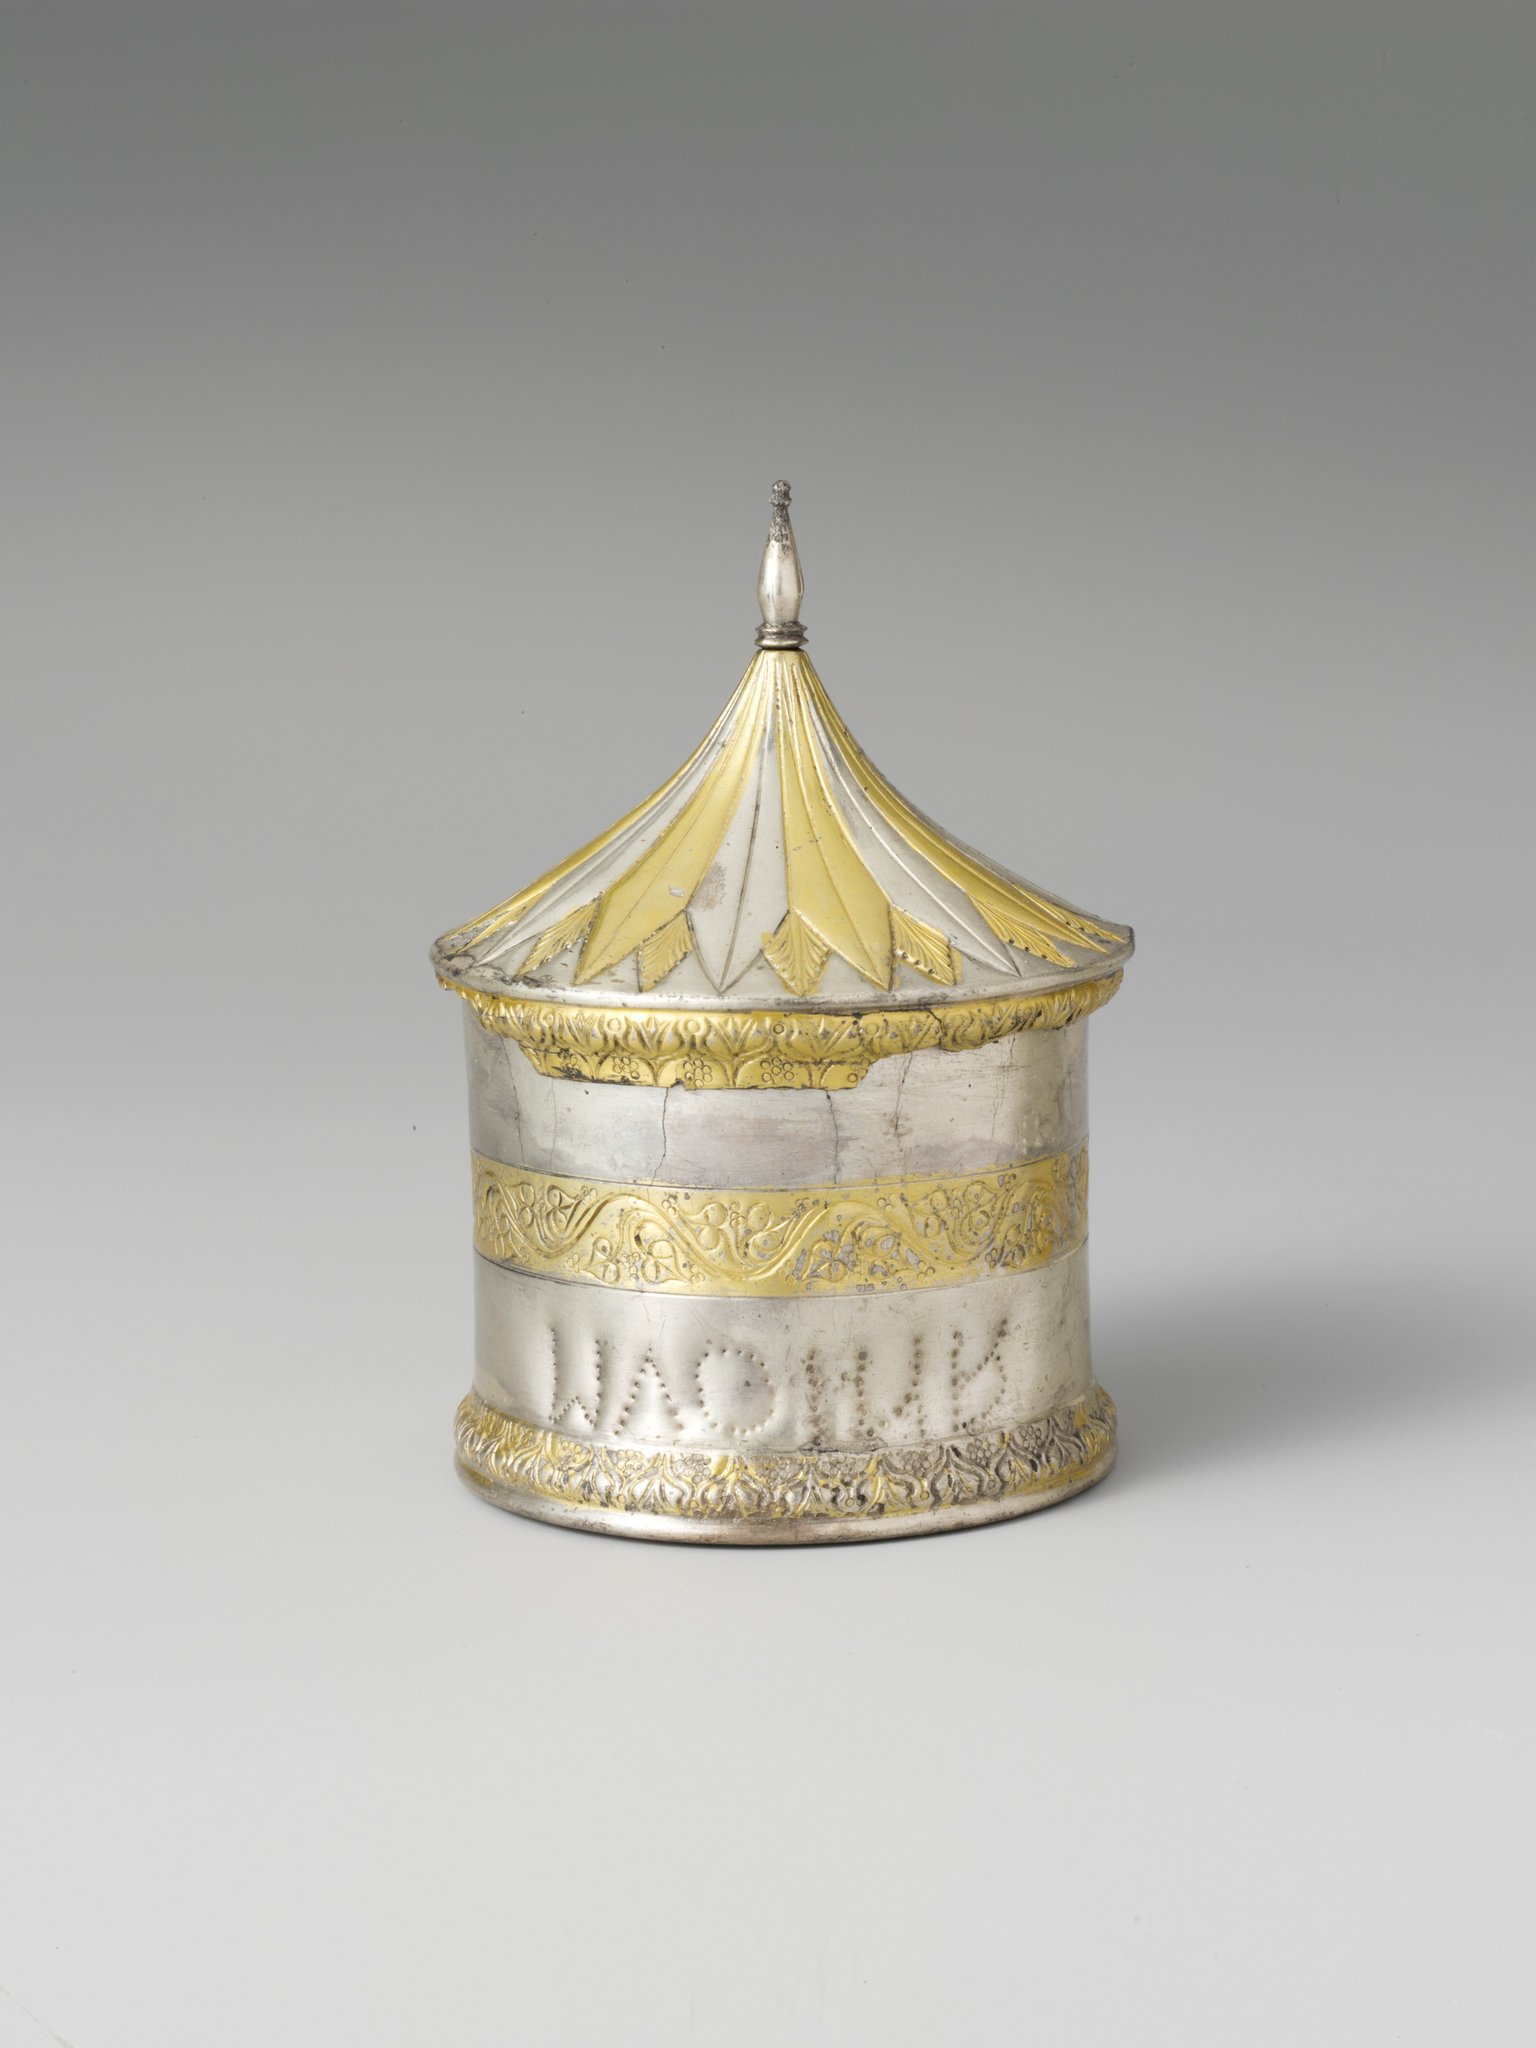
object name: pyxis with lid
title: Silver and gilt pyxis (box with lid)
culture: apulian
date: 300-268 BCE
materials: gold, silver